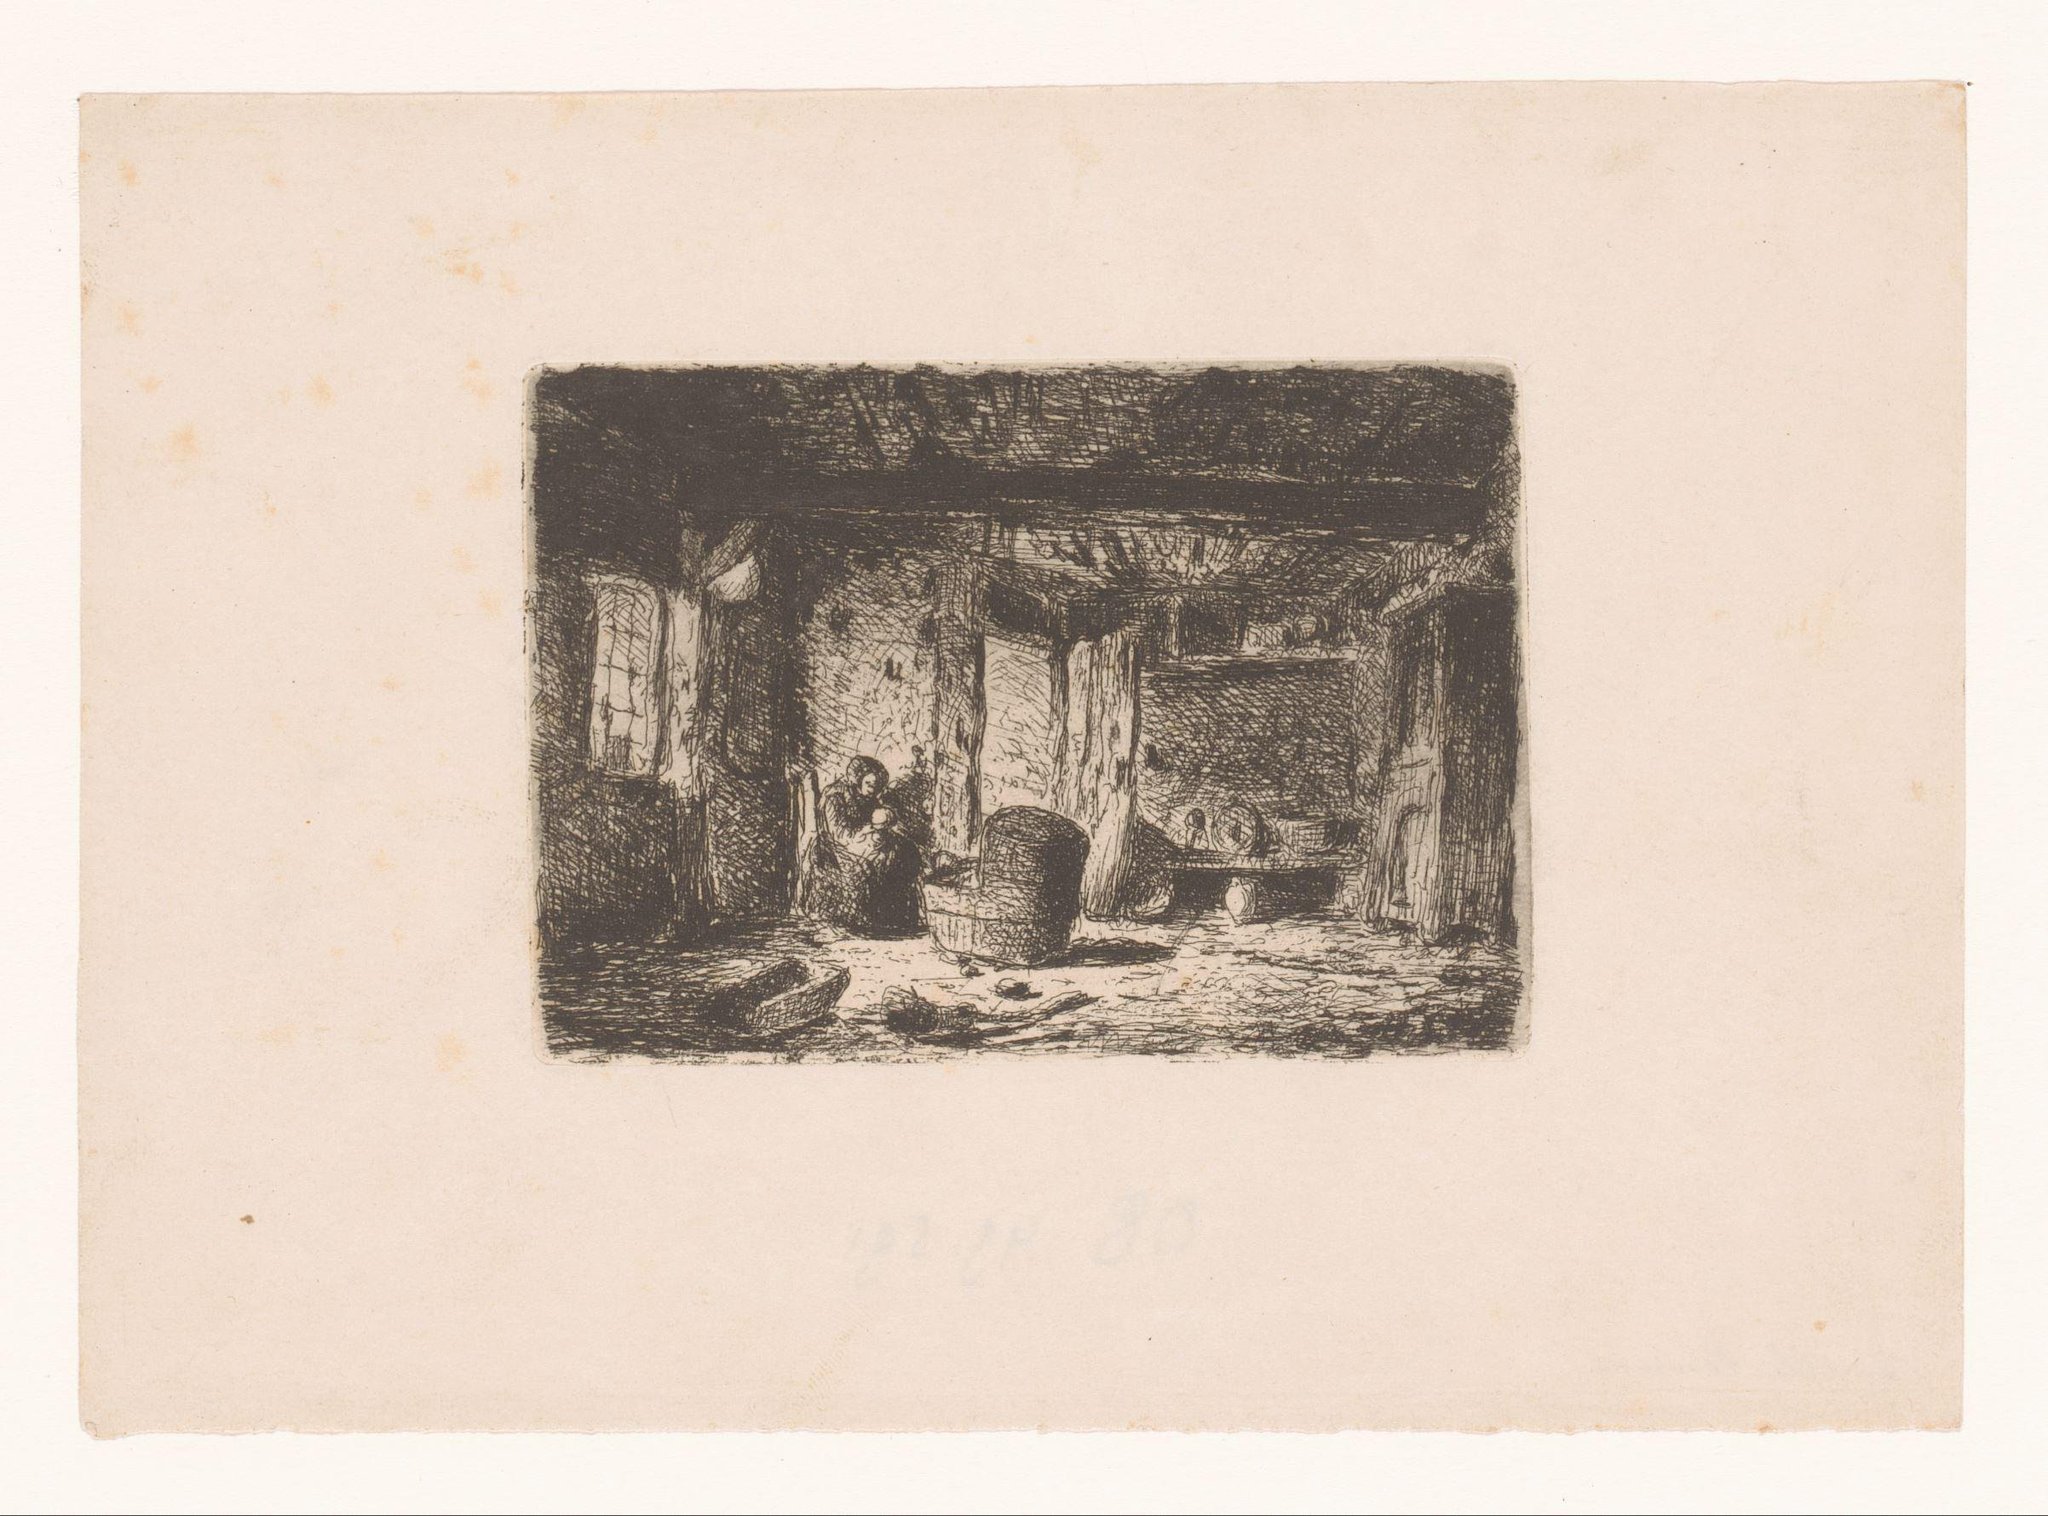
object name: print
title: Interieur met vrouw bij wieg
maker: camille venneman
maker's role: painter, print maker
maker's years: 1827-1868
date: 1857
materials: paper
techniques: drypoint, etching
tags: cradle, crib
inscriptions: collector's mark: Lugt 2228